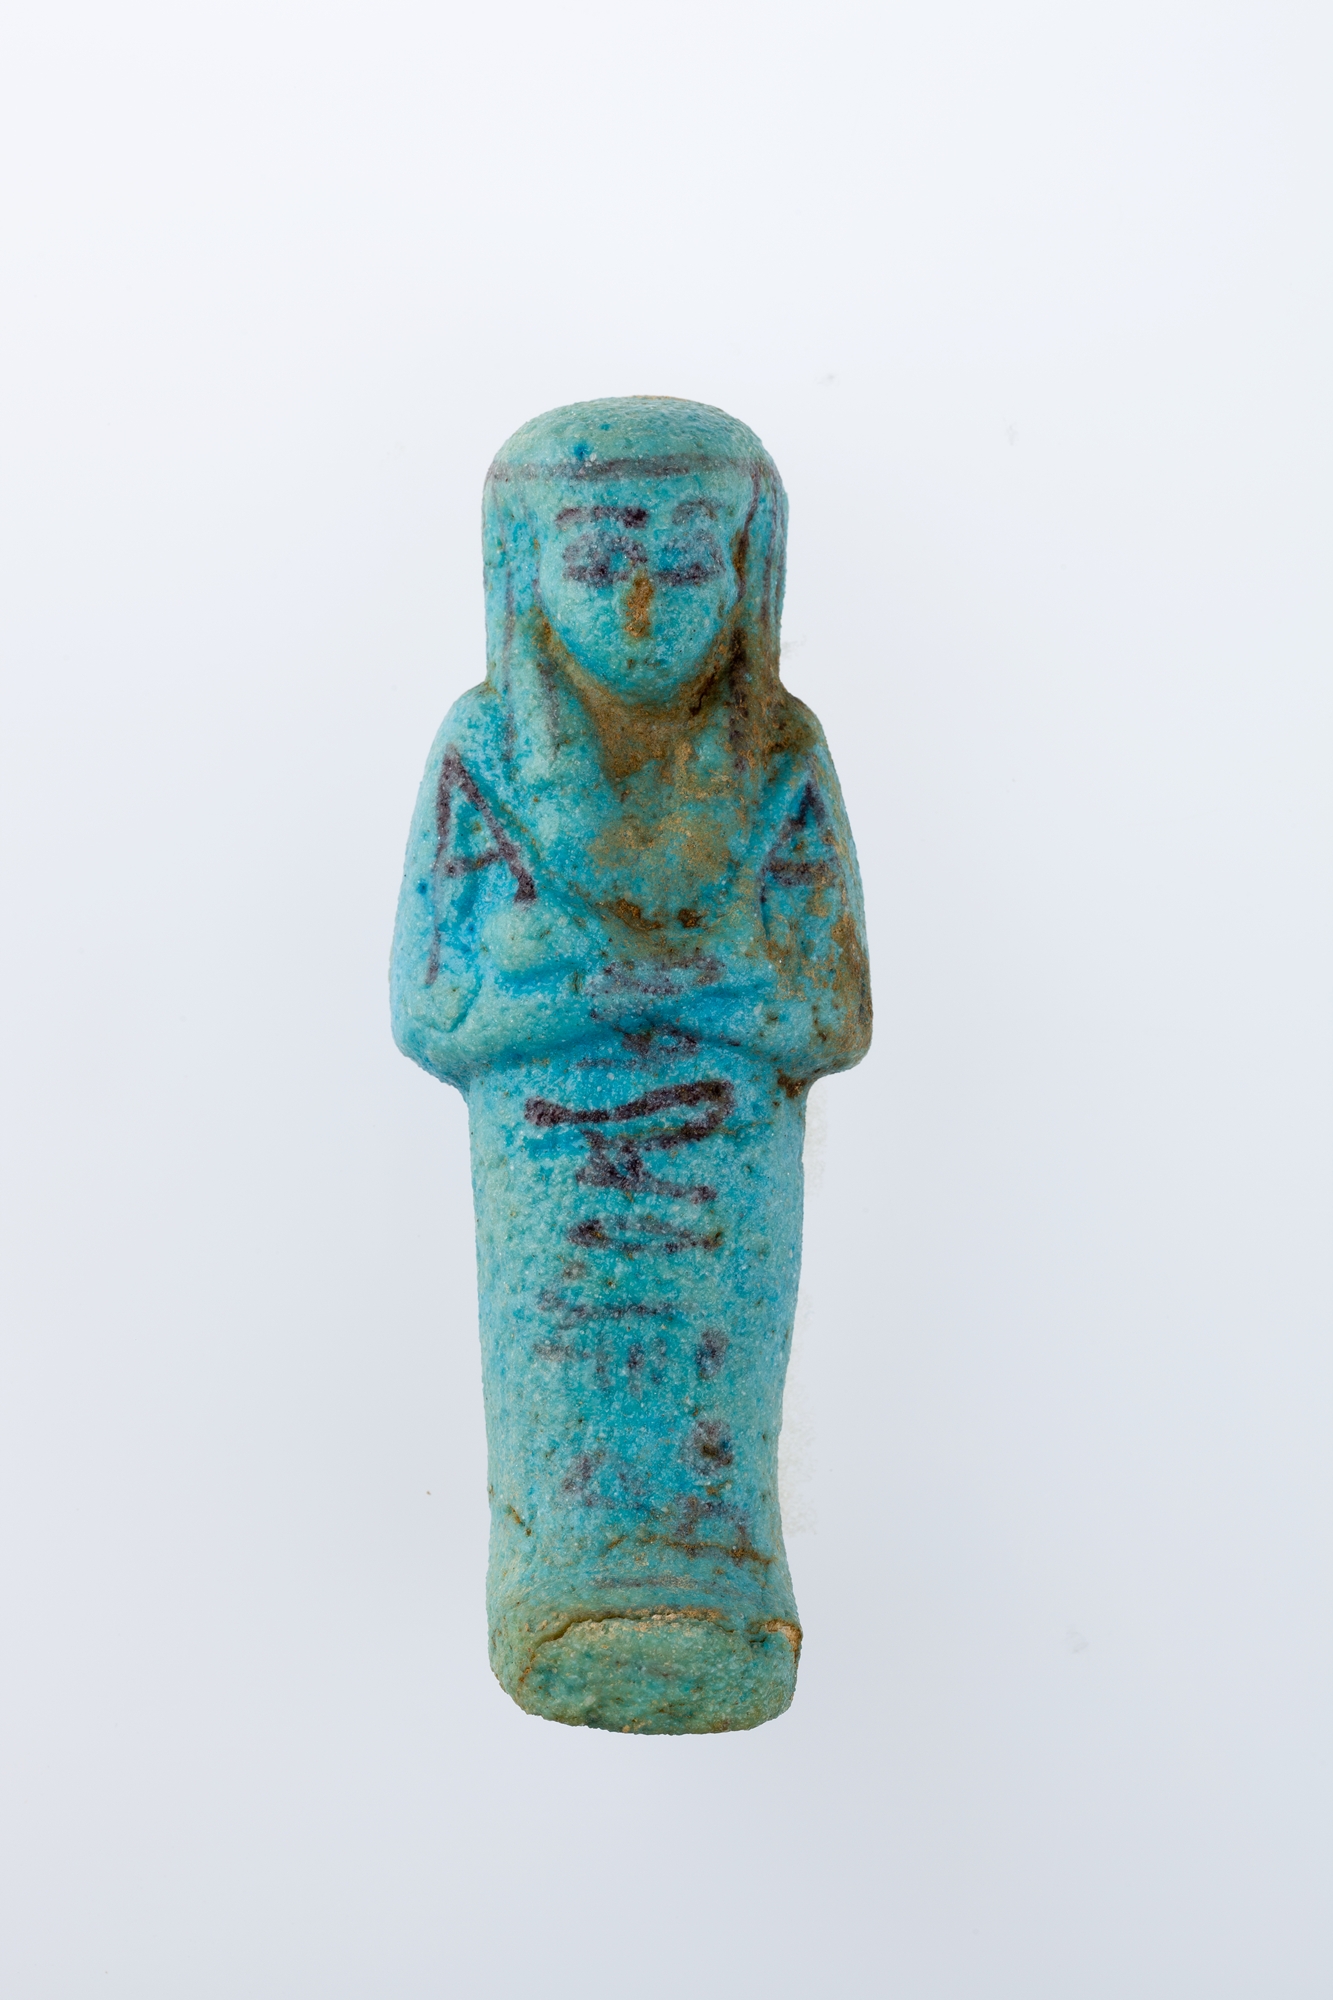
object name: shabti, henettawy c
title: Worker Shabti of Henettawy (C), Daughter of Isetemkheb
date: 990-970 BCE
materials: faience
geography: egypt